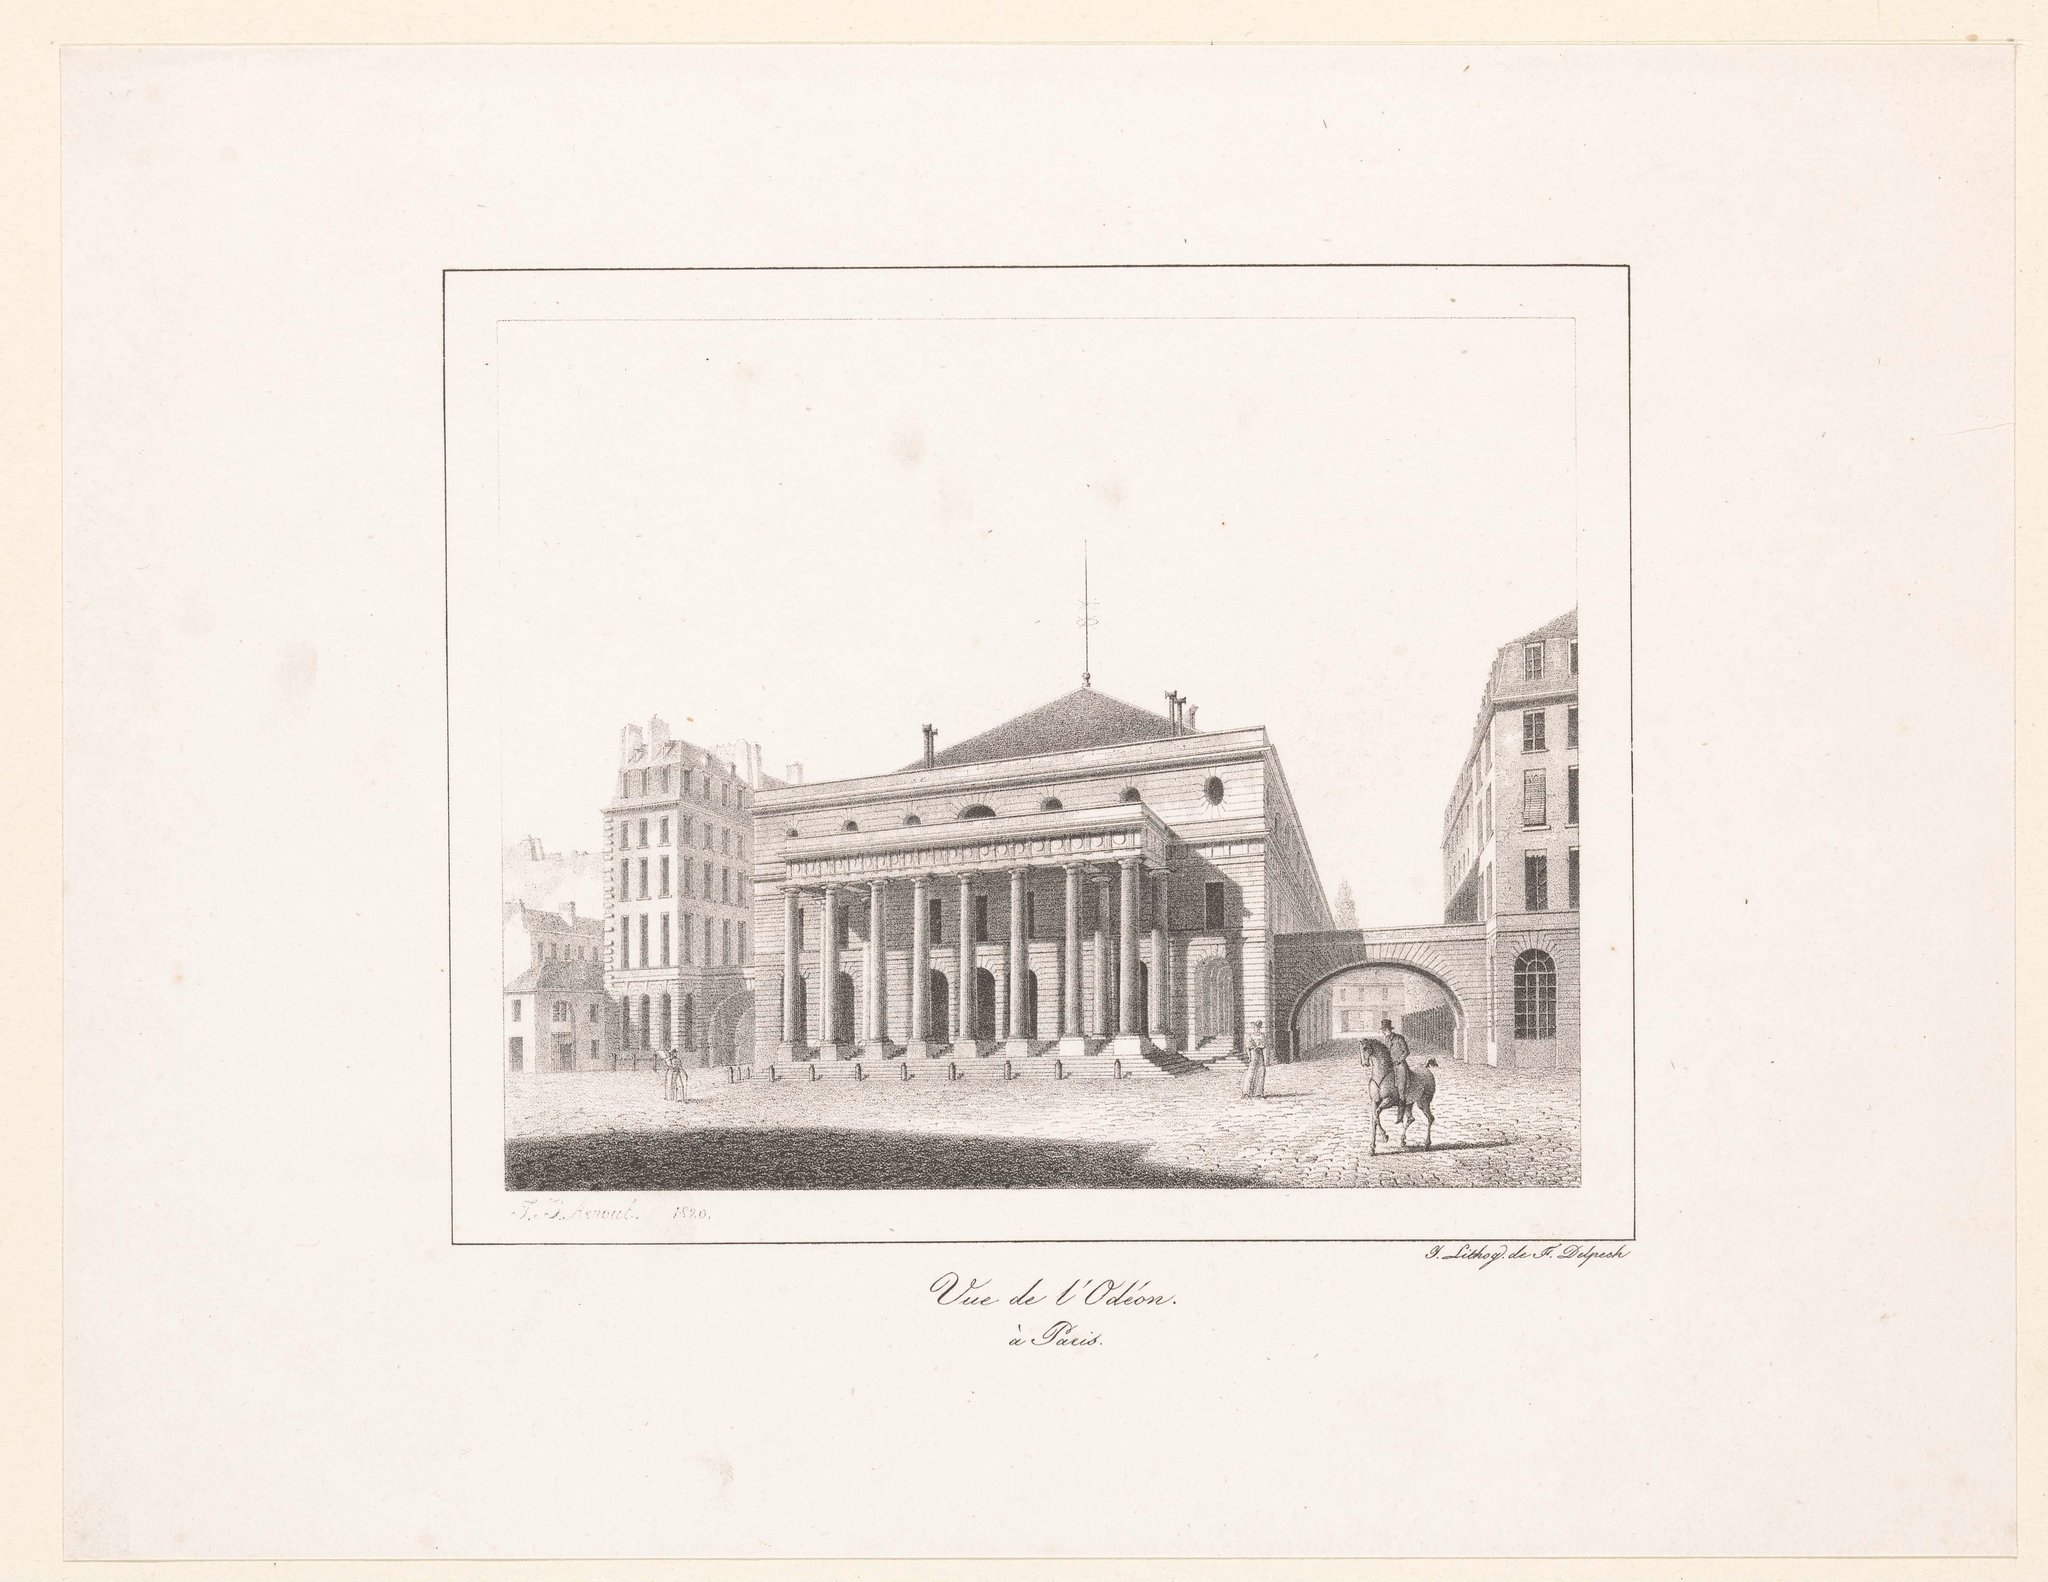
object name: print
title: Vue de l'Odéon à Paris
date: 1820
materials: paper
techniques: lithograph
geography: paris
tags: theatre (building), paris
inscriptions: date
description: De serie waar deze prent deel van uit maakt, bestaat waarschijnlijk uit dertig prenten.